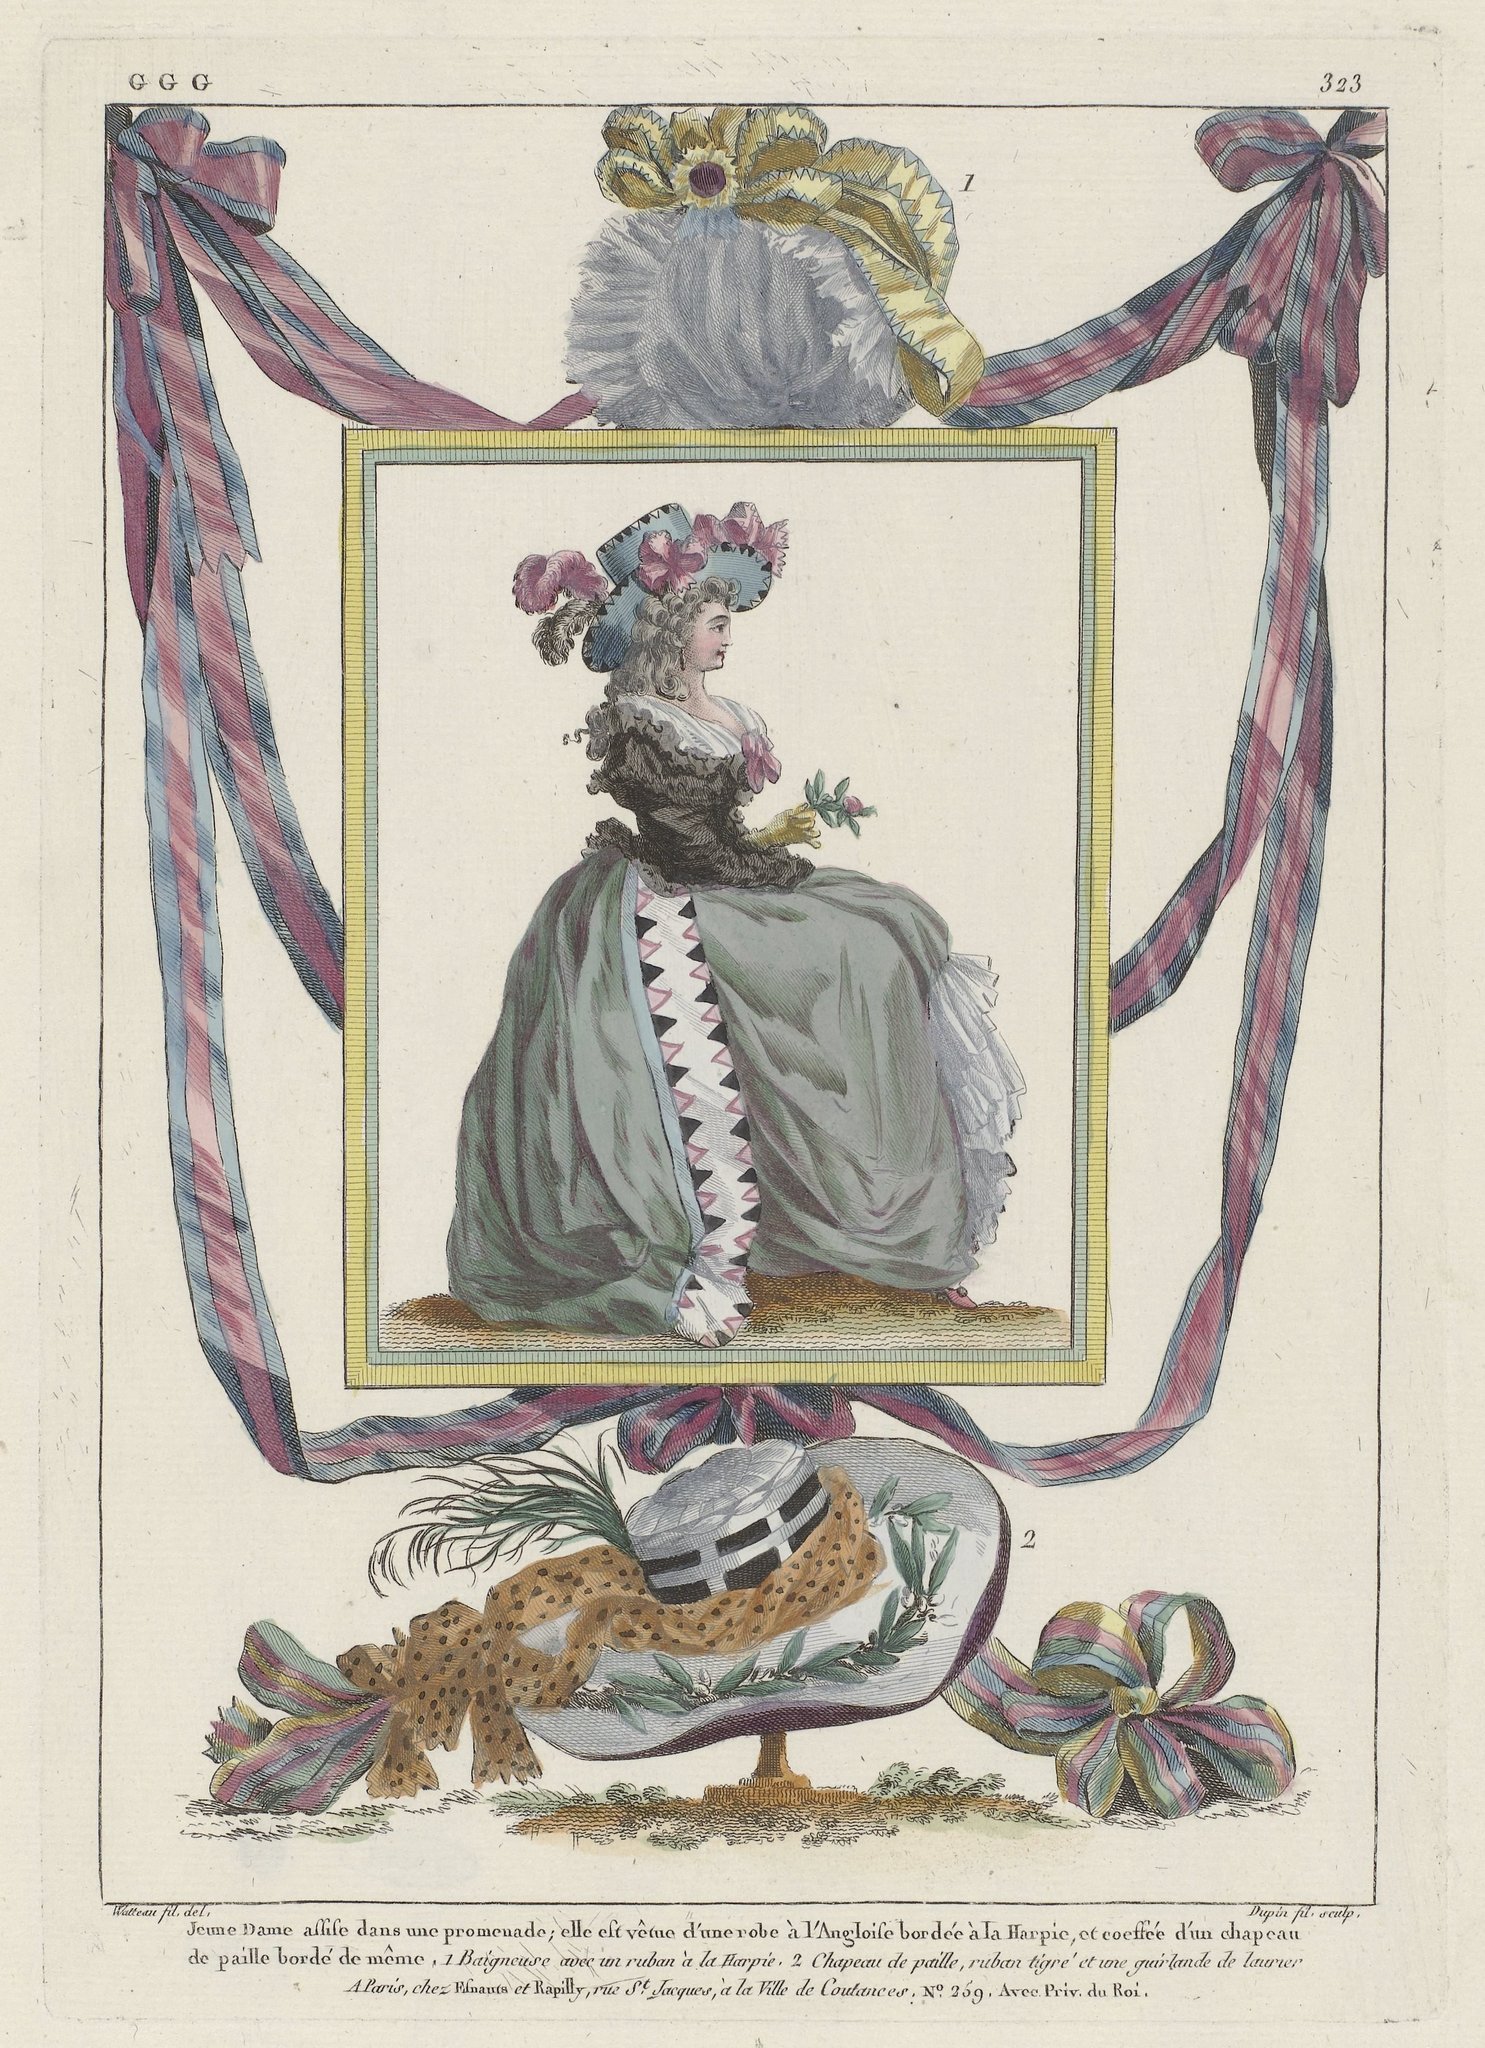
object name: fashion print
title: Gallerie des Modes et Costumes Français, 1787, GGG 323: Jeune dame assise dans une promenade; (...)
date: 1787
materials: paper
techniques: engraving, hand coloring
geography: paris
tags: ear-rings (+ women's clothes), cut flowers; nosegay, bunch of flowers, border, ribbon, braid (+ women's clothes), dress, gown: robe à l'anglaise (+ women's clothes), clothing for the upper part of the body (mantelet) (+ women's clothes), head-gear (baigneuse) (+ women's clothes), head-gear (straw hat) (+ women's clothes), head-gear: cap (+ women's clothes), fashion plates, head-gear: hat (+ other materials used for clothes), piece of clothing covering the breast or décolleté (fichu) (+ women's clothes)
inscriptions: caption: ‘Jeune dame assise dans une promenade; elle est vêtue d'une robe à l'Angloise bordée à la Harpie, et coeffée d'un chapeau de paille bordé de même. 1 Baigneuse avec un ruban à la Harpie. 2 Chapeau de paille, ruban tigré et une guirlande de laurier.’, address: ‘A Paris chez Esnauts et Rapilly, rue St. Jacques, à la Ville de Coutances, No. 259. Avec Priv. du Roi.’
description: Jonge vrouw, zittend tijdens een wandeling, in een 'robe à l'Anglaise' afgezet 'à la Harpie' (gekarteld patroon). Op het hoofd een strohoed afgezet met eenzelfde versiering. Fichu en kleine schoudermantel. Accessoires: oorbel in het rechteroor, handschoenen. Zij zit in een kader, waaromheen gestreepte linten zijn gedrapeerd en boven en onder een hoed is afgebeeld. 1. 'Baigneuse' met een lint 'à la Harpie'. 2. Strohoed met gestippeld lint en een guirlande van laurier. Uit serie GGG. 51e Cahier de Costumes Français, 45e Suites d'habillemens à la mode en 1787, Gallerie des Modes et Costumes Français.